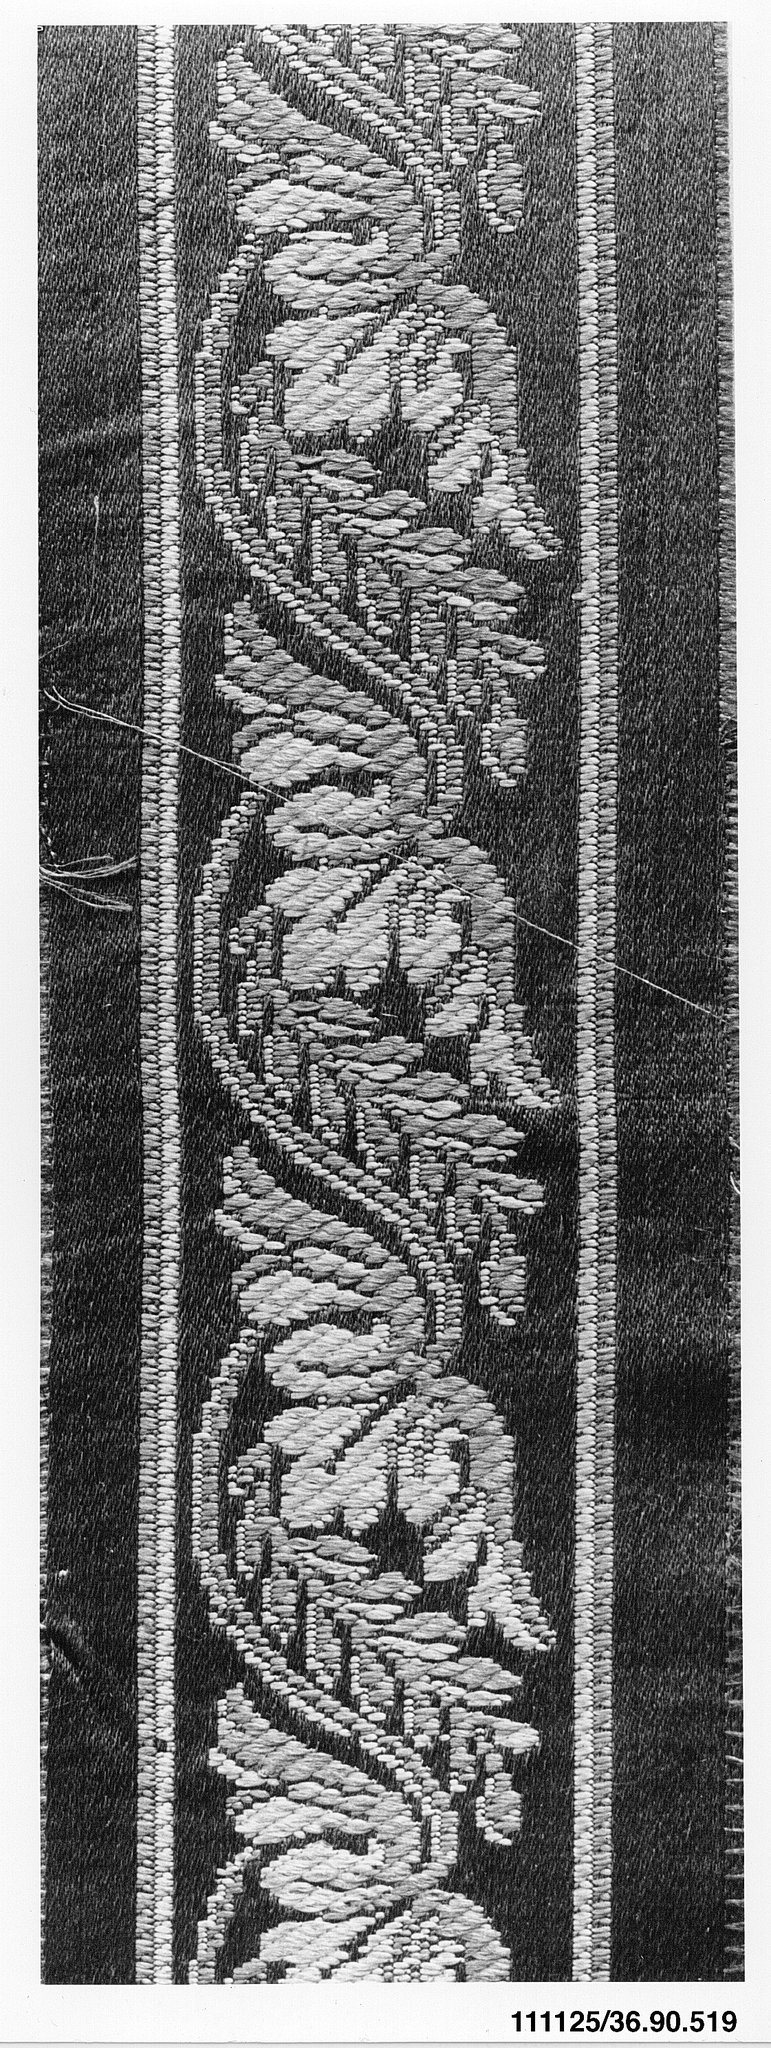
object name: piece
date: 1801-1833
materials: silk